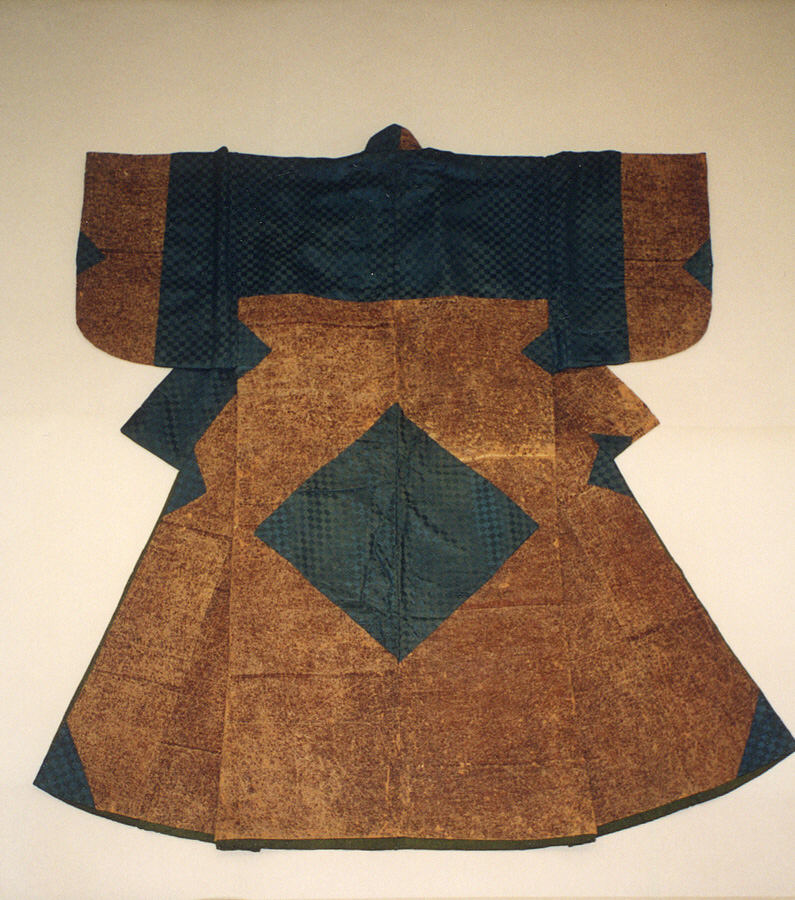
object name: paper robe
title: Man's Paper Garment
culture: japanese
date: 1801-1900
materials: paper, silk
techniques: damask